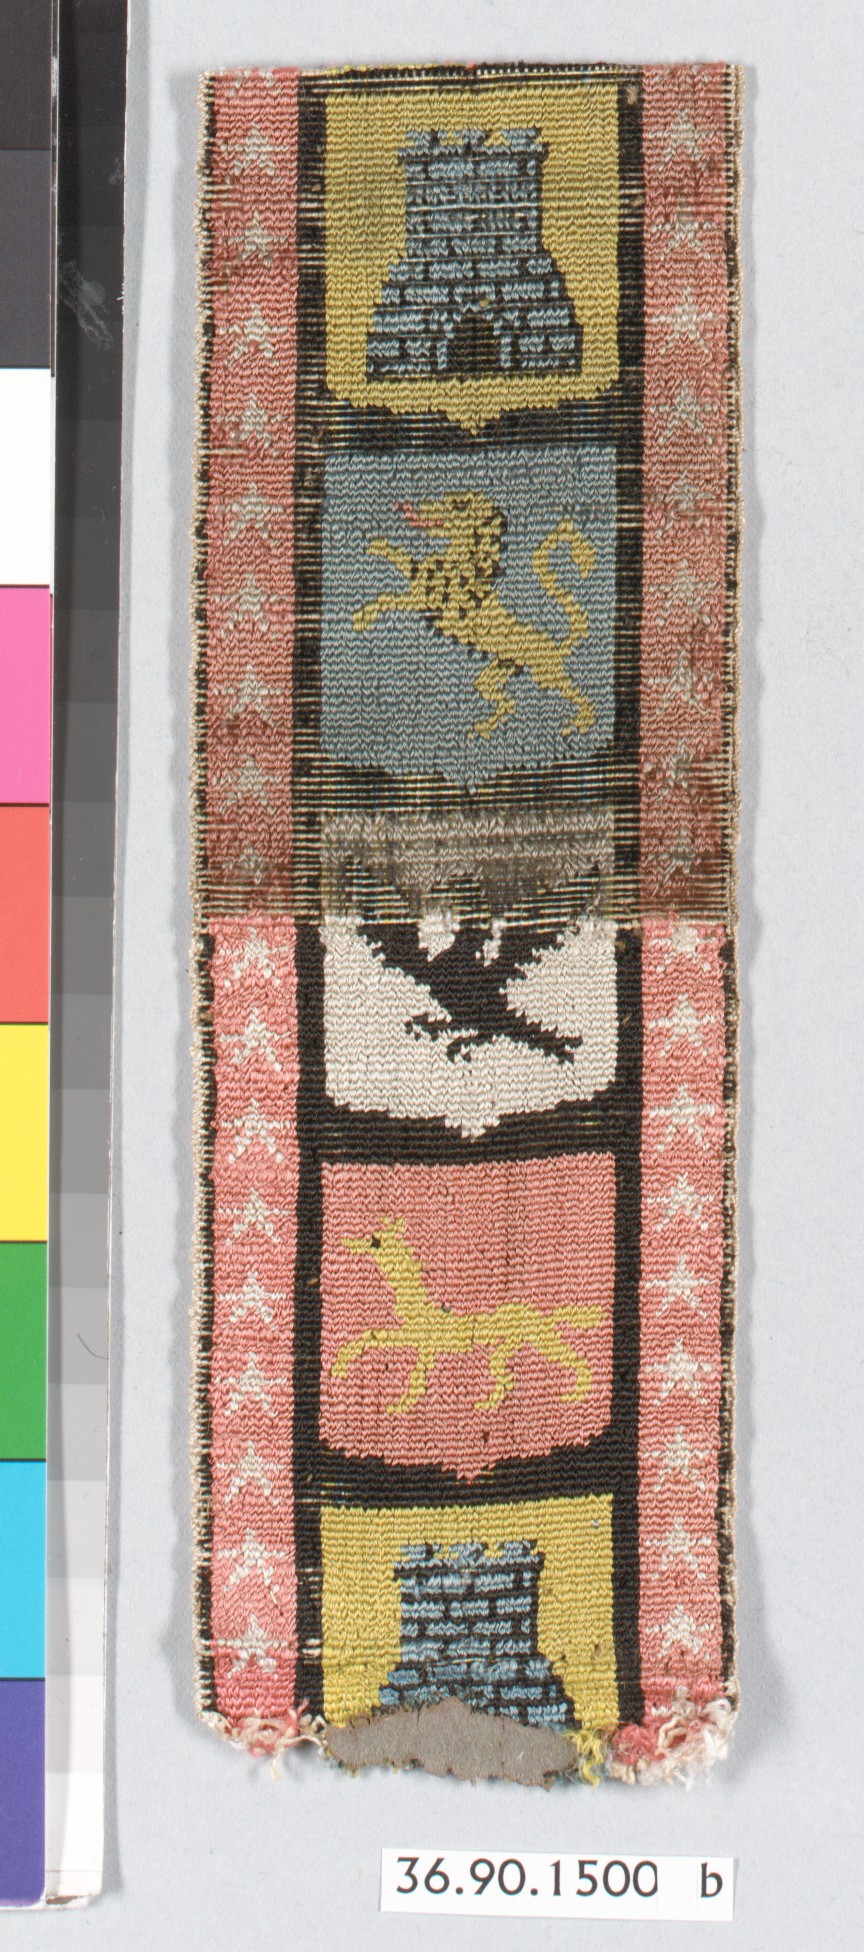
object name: galloon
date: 1701-1900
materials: silk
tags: animals,birds